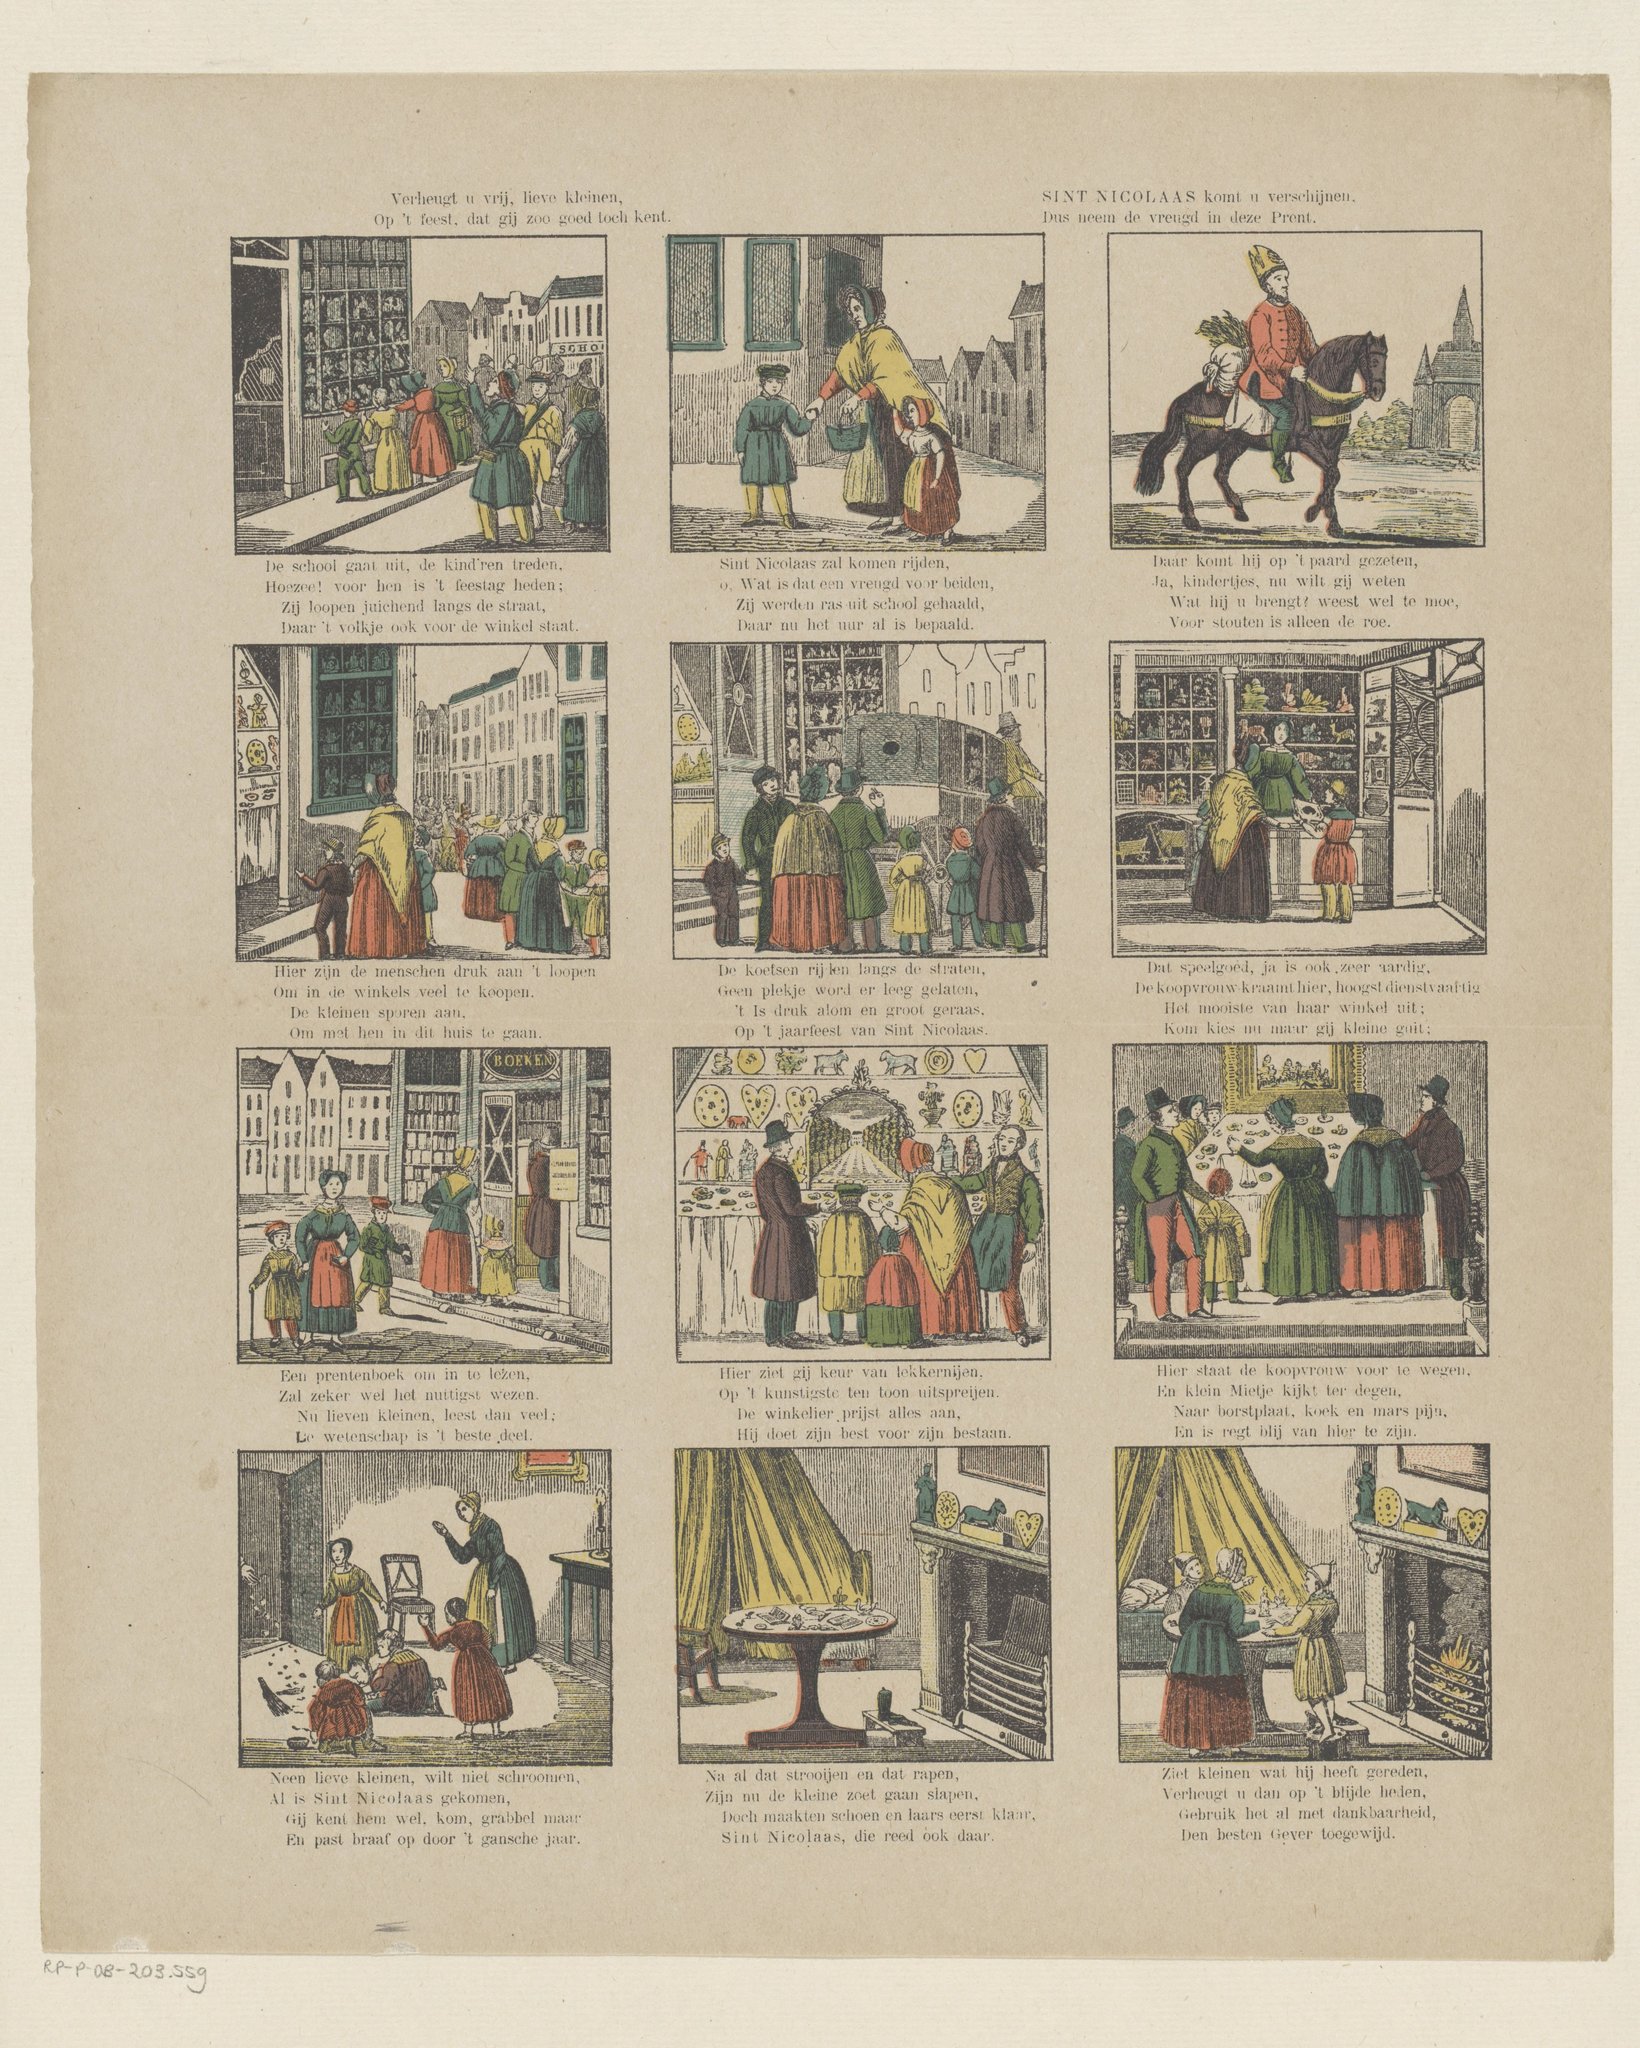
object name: popular print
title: Verheugt u vrij, lieve kleinen, / Op 't feest, dat gij zo goed toch kent / Sint Nicolaas komt u verschijnen / Dus neem de vreugd in deze prent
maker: Anonymous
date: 1894-1959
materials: paper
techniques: colour, letterpress printing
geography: liège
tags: the bishop nicholas of myra (or bari); possible attributes: anchor, boat, three golden balls (on a book), three purses, three children in a tub, three maidens, festivities on st. nicholas (eve) (december 5)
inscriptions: collector's mark: Lugt 2760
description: Blad met 12 voorstellingen over Sint Nicolaas en het Sinterklaasfeest. Onder elke afbeelding een vierregelig vers.